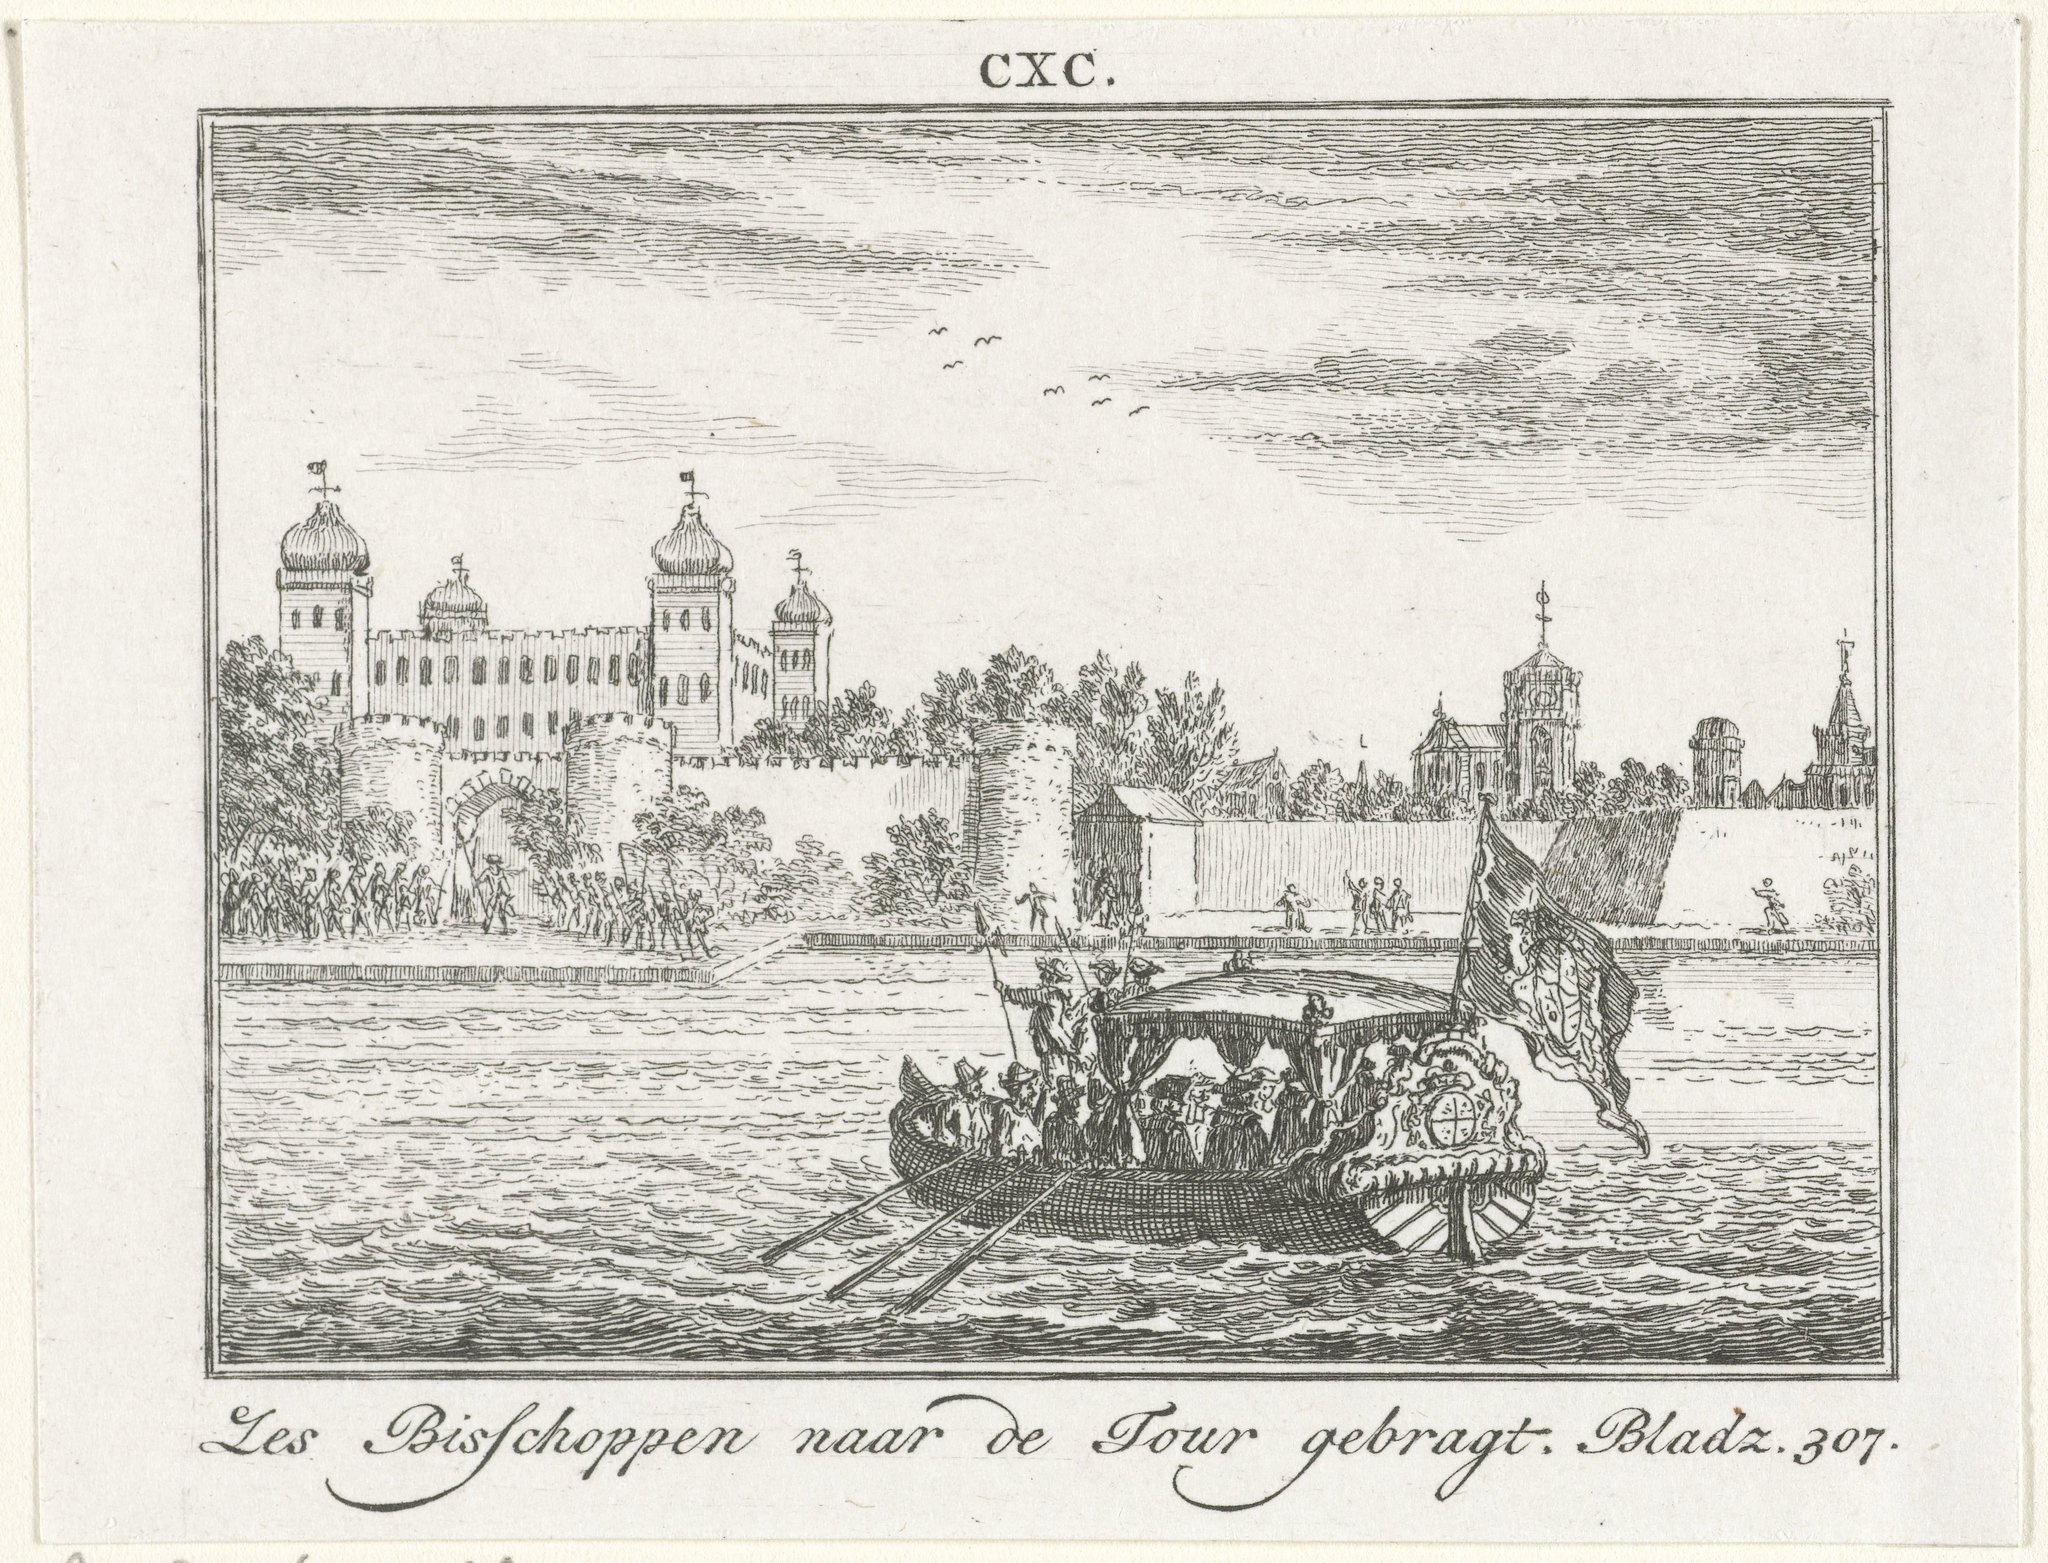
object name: print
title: Gevangen genomen bisschoppen worden naar de Tower gebracht, 1688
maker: simon fokke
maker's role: draughtsman, print maker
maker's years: 1712-1784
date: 1722-1784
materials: paper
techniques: etching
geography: amsterdam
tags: imprisonment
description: Voorstelling uit de wereldgeschiedenis. Per boot worden gevangen genomen bisschoppen naar de Tower of Londen gebracht, in de verte is deze gevangenis te zien. Voorstelling bovenaan genummerd: CXC